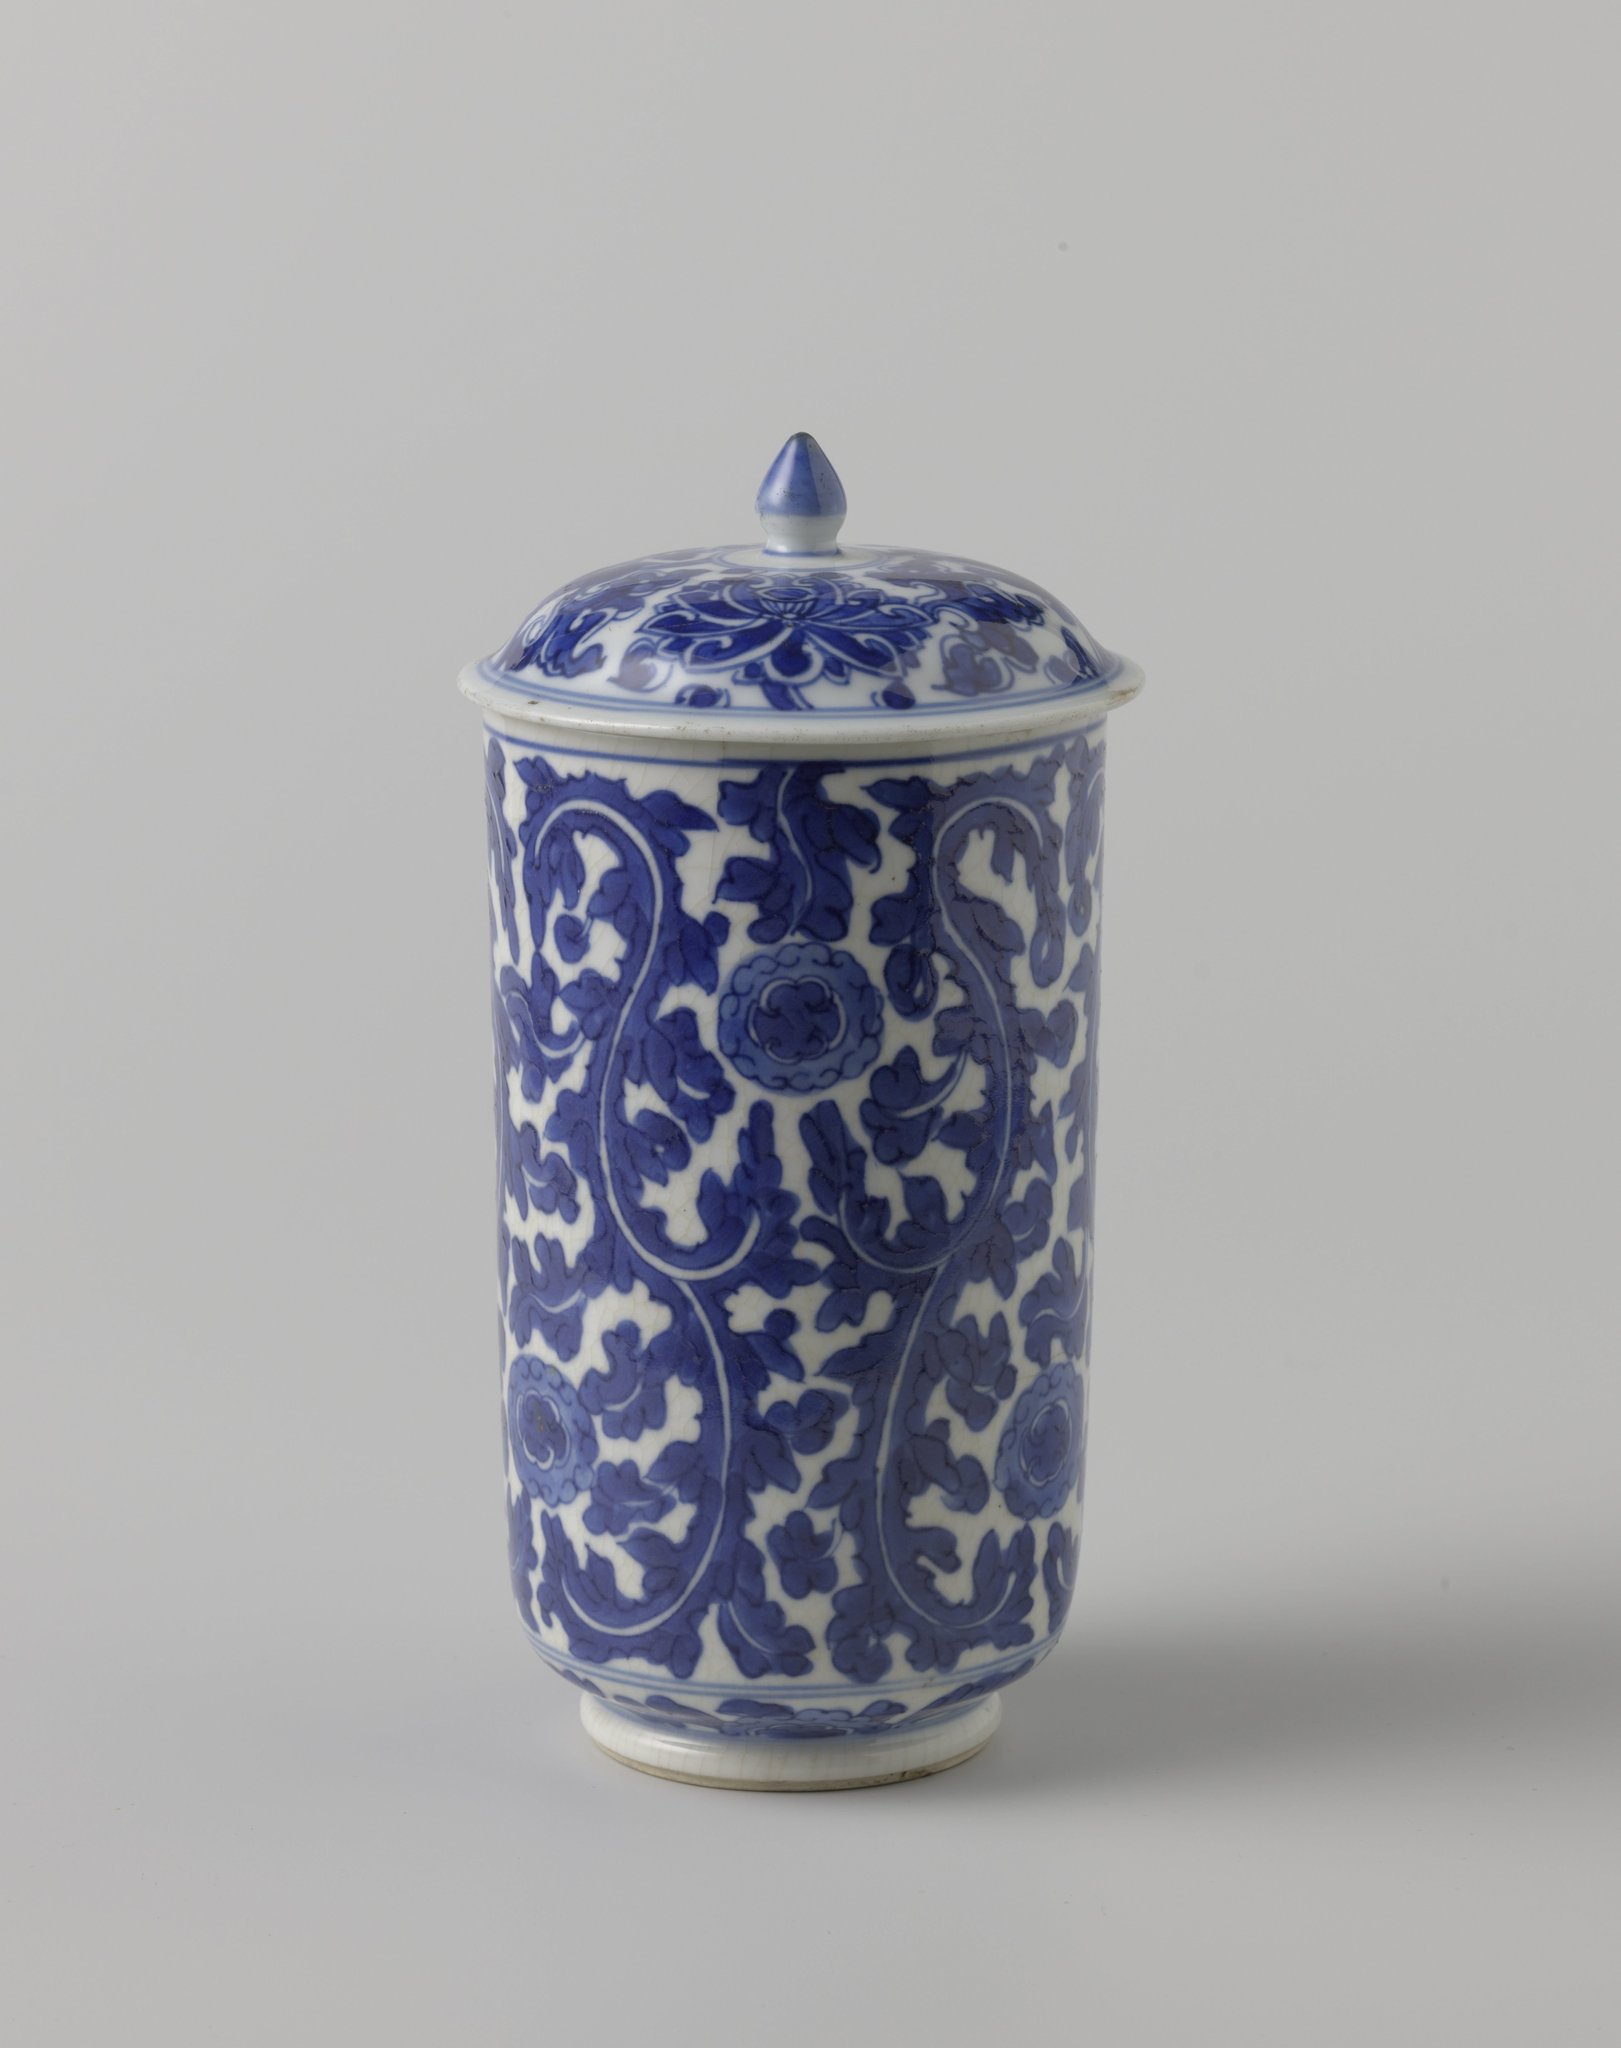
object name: cup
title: Covered cylindrical beaker with leaf-motif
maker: Anonymous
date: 1680-1720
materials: cobalt, glaze, paint, porcelain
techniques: firing, turning, vitrification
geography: china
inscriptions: mark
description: Deksel van cilindrische beker met deksel van porselein, beschilderd in onderglazuur blauw. Versierd met een doorlopend, krullend bladmotief afgewisseld met bloemrozetten (tijgerlelie-motief). Niet bijbehorend deksel met lotusranken. Een chip in de deksel. Blauw-wit.